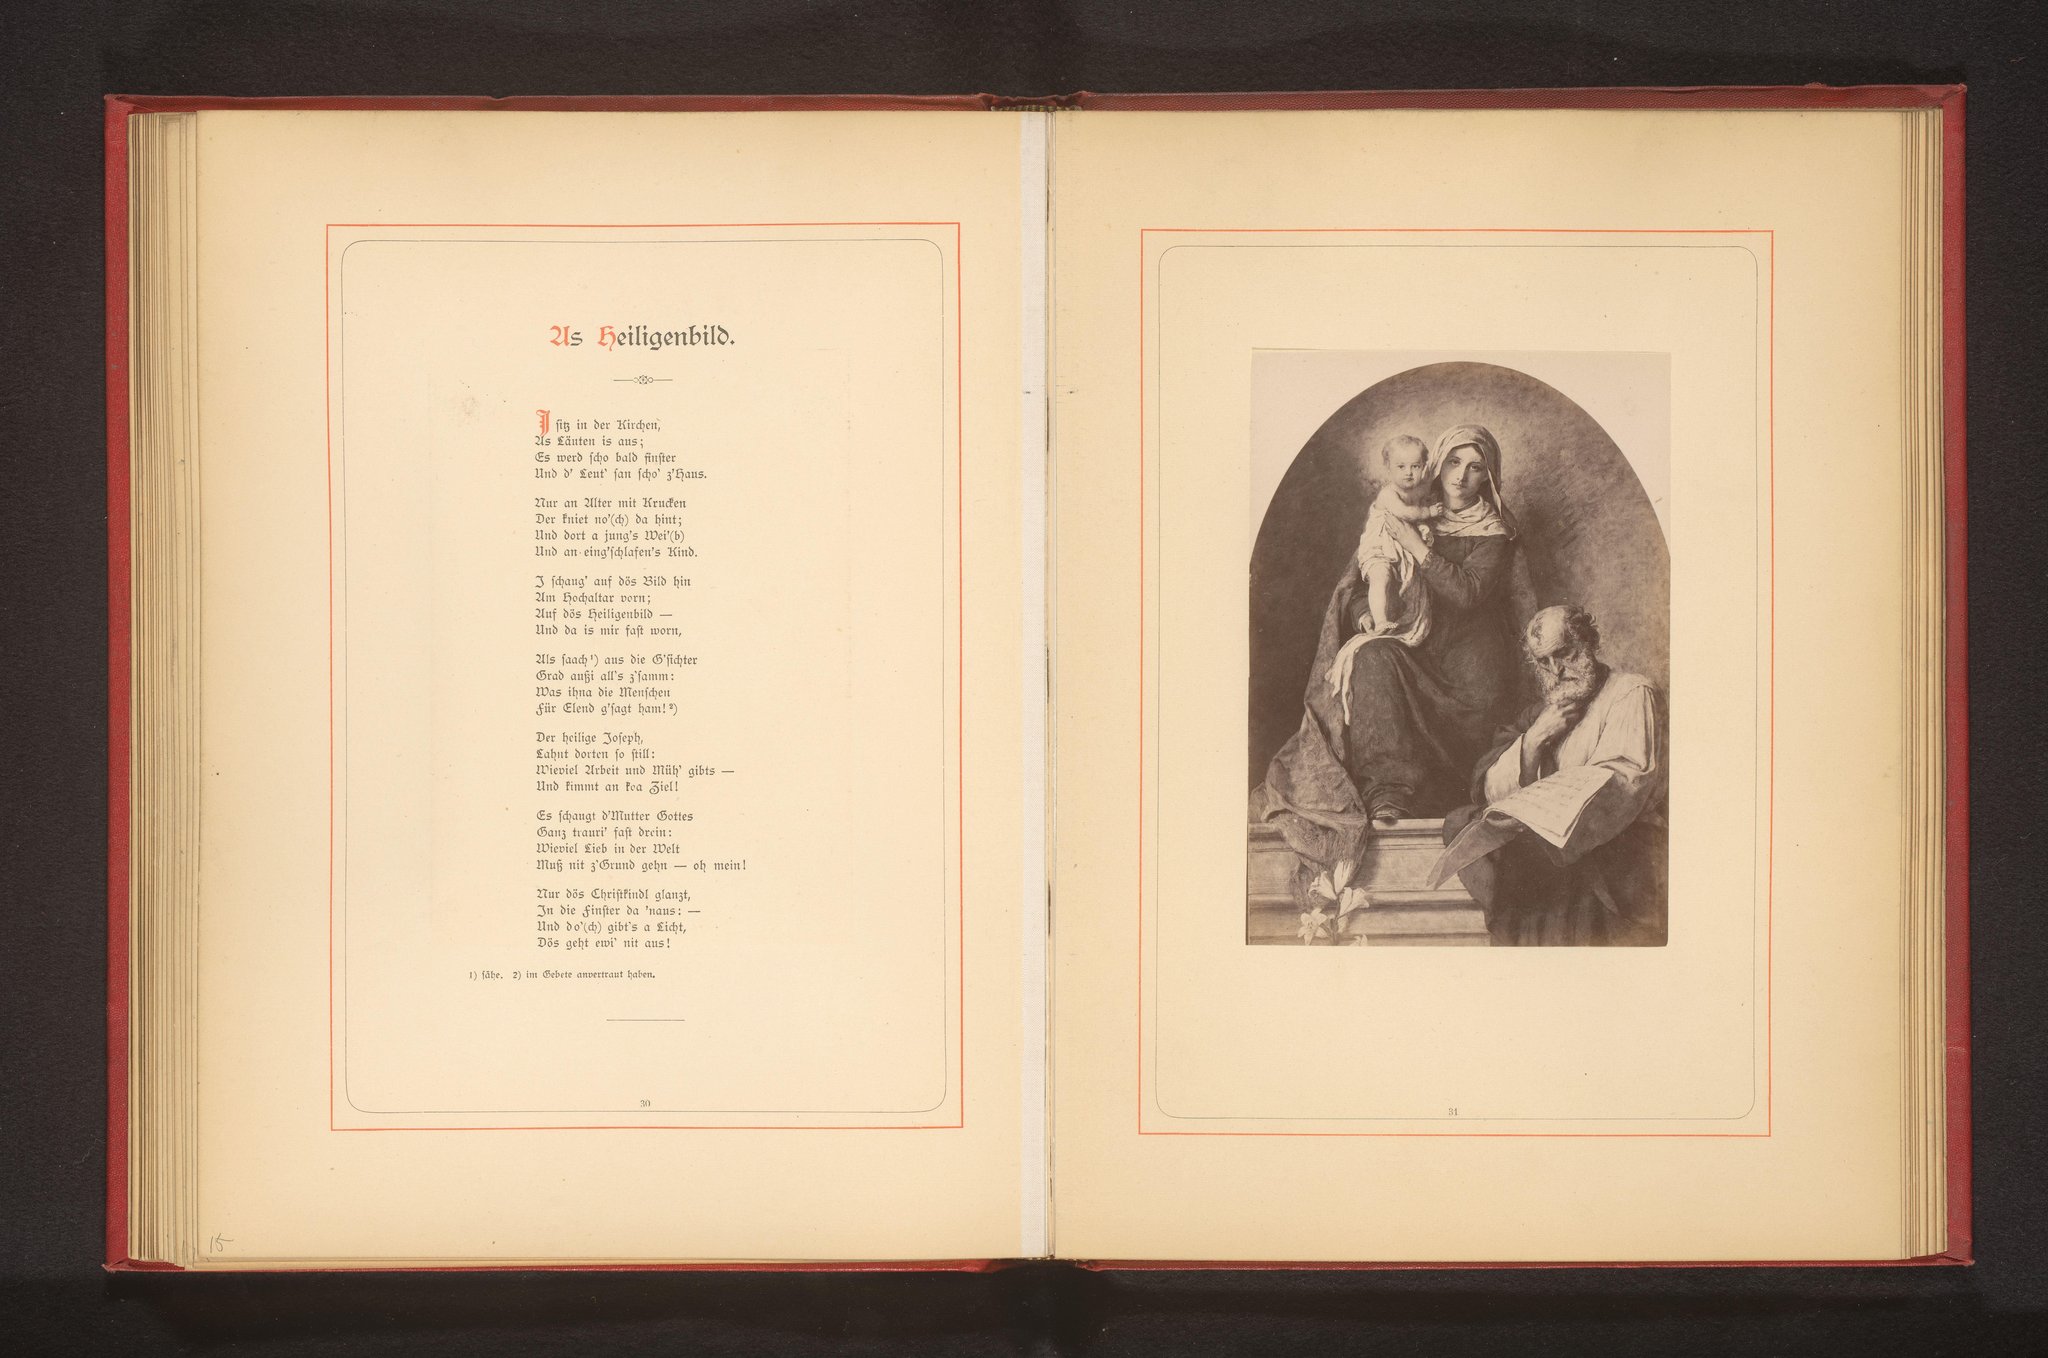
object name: page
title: Fotoreproductie van een schilderij, voorstellende de Heilige Familie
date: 1873-1883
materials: photographic support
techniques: albumen print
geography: germany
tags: holy family, and derived representations